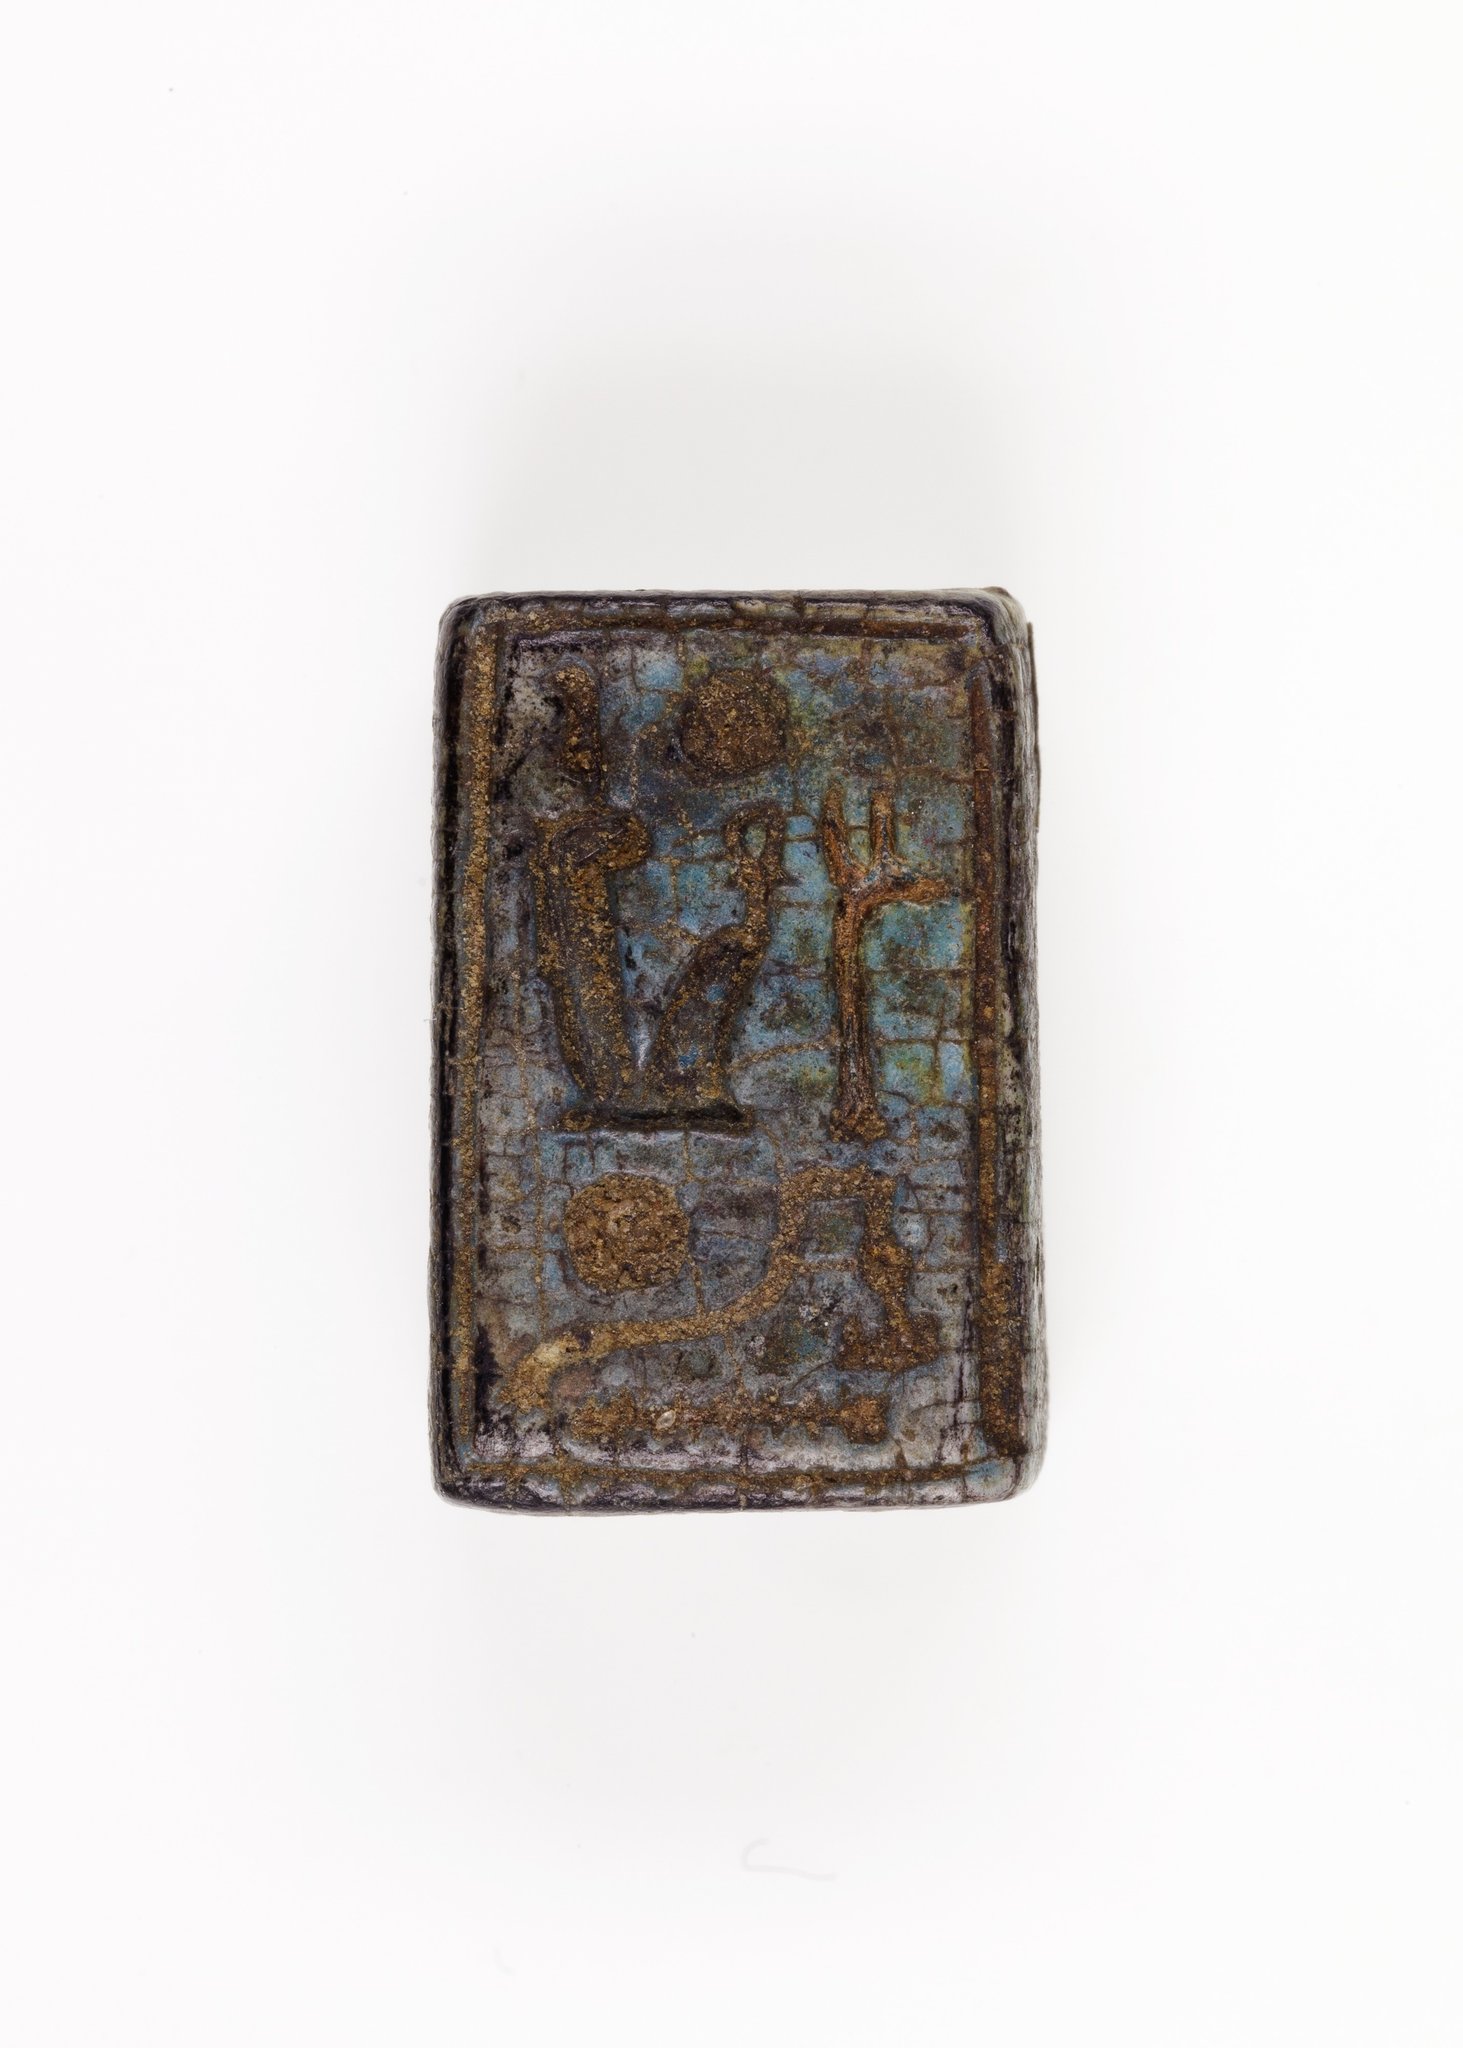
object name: stamp, amulet, seal plaque, paser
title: Amuletic plaque of Paser, the Vizier of Seti I and Ramesses II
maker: paser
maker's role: patron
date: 1294-1213 BCE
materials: faience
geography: egypt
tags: hieroglyphs